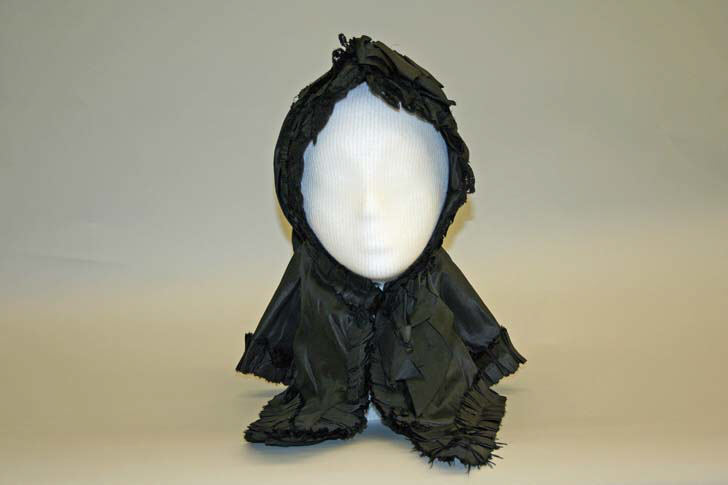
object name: hood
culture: american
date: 1834-1866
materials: silk